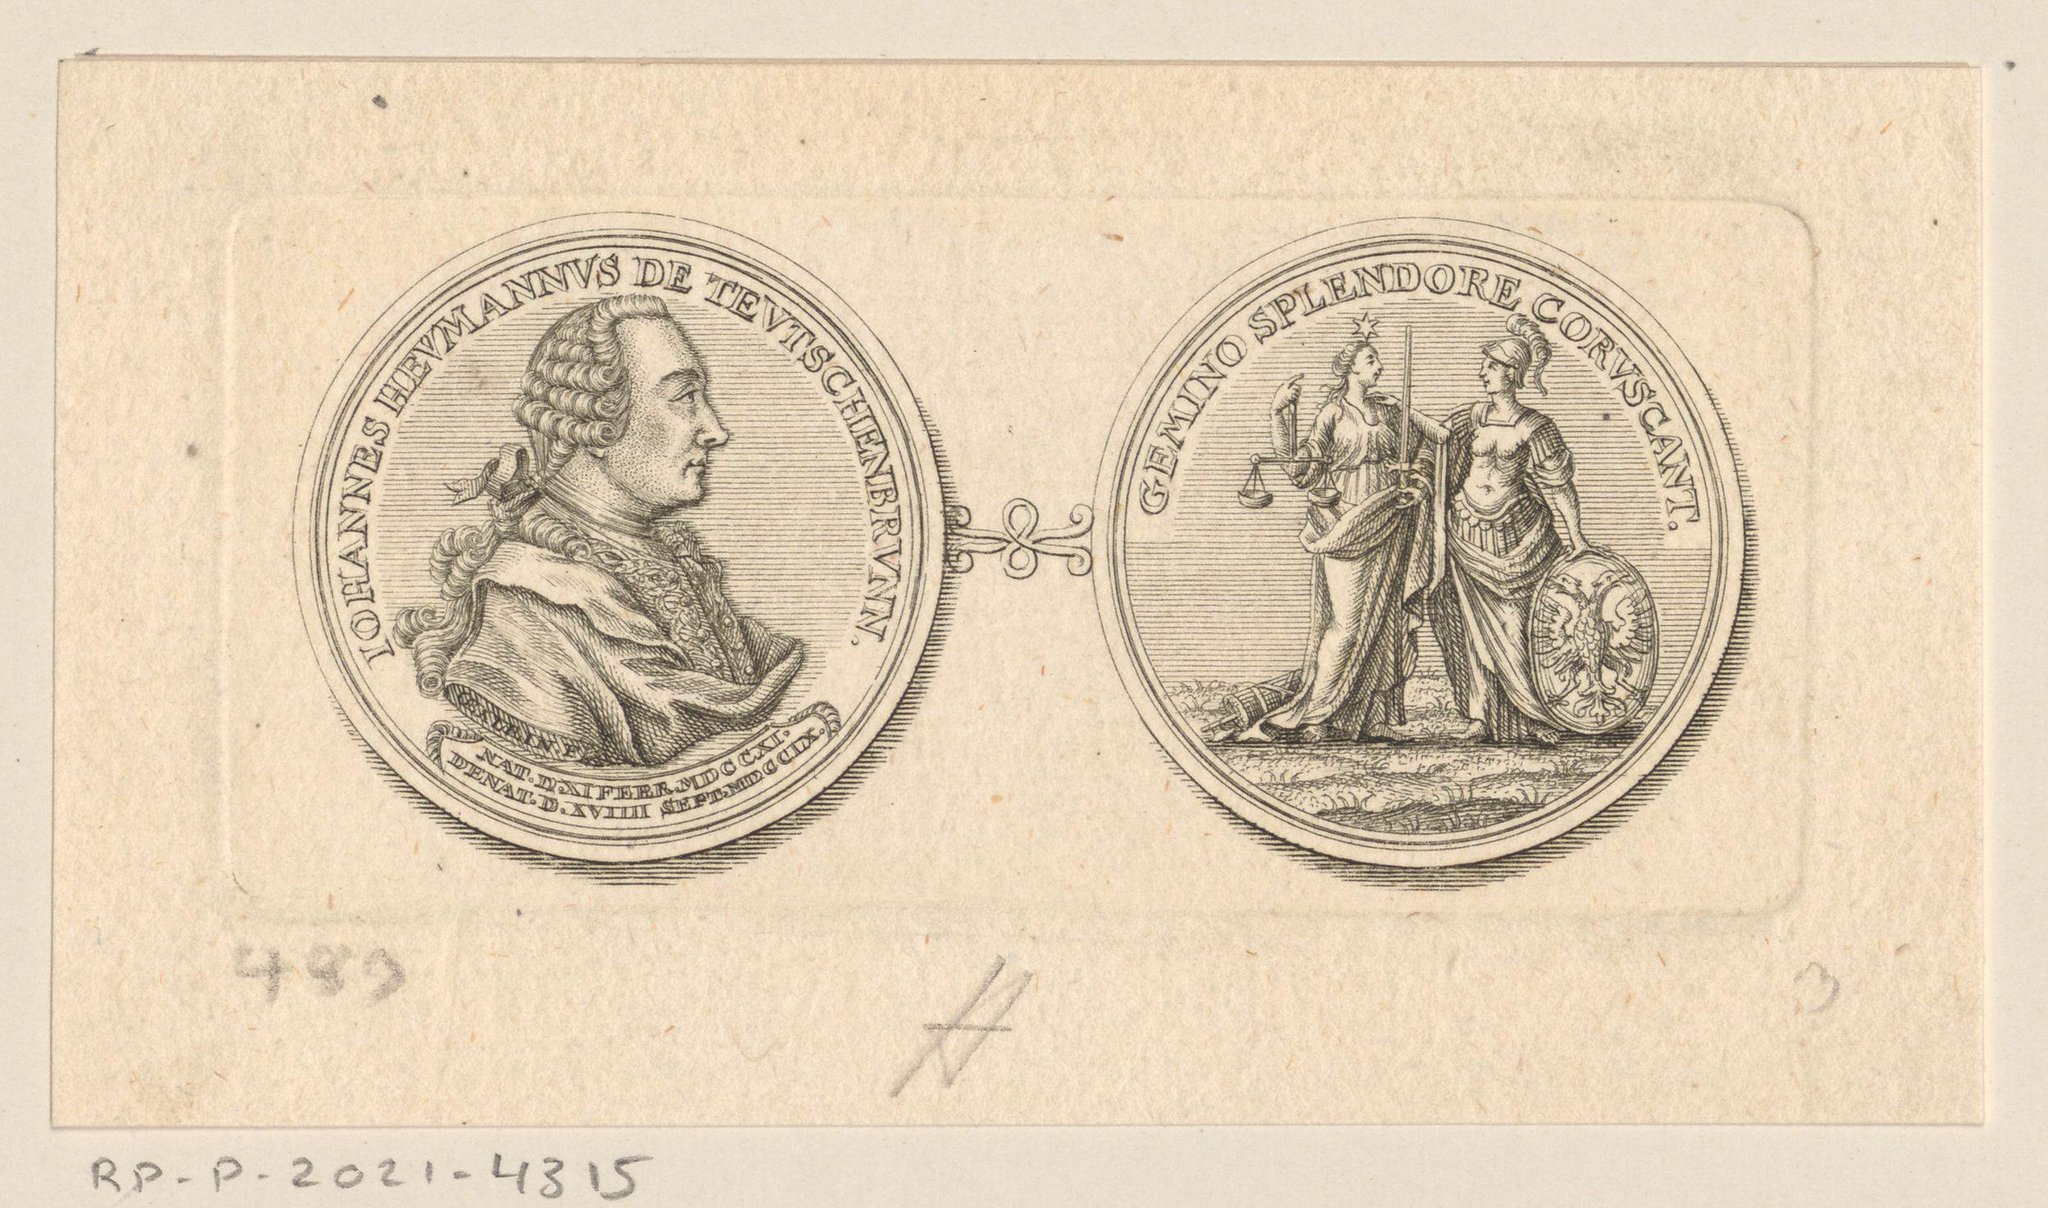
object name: print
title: Penning met portret van Johann Heumann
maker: johann sebastian leitner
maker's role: print maker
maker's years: 1715-1795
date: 1760-1795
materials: paper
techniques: etching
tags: (story of) minerva (pallas, athena), historical persons, medal (considered as a piece of sculpture, regardless of its specific function), justitia (justice) as roman personification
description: Prent mogelijk uit: Will, Georg Andreas. Nürnbergische Münzbelustigungen. Altdorf: Georg Peter Monath, 1764-1767.